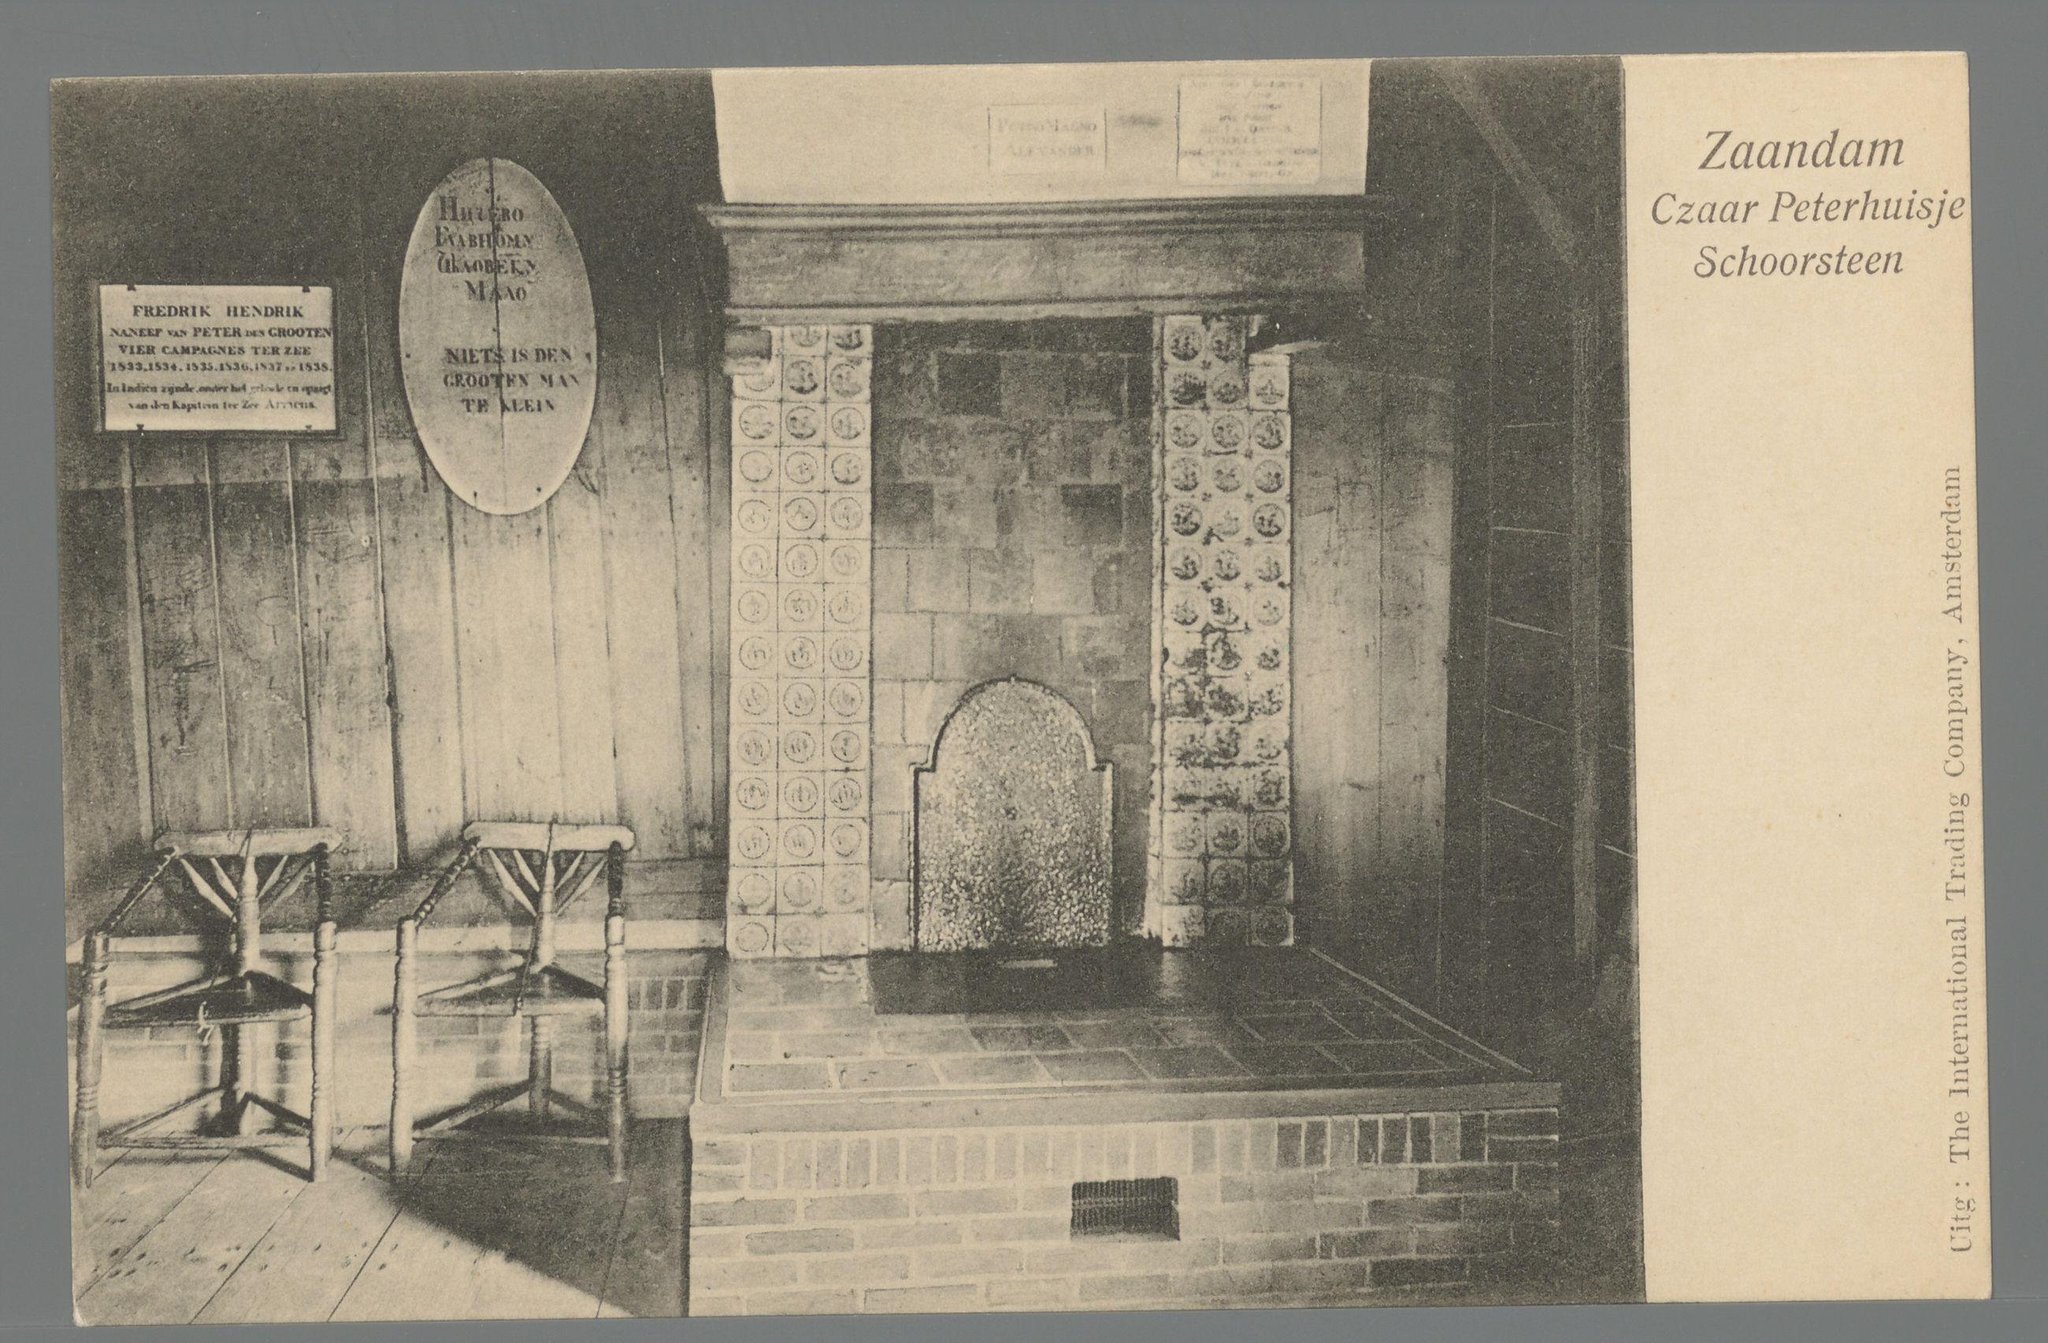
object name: ansichtkaart, prentbriefkaart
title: Zaandam. Czaar Peterhuisje. Schoorsteen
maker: Anonymous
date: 1897-1905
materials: cardboard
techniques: photograph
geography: zaandam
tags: interior of the house, permanent exhibition, museum, chimney-piece, mantelpiece